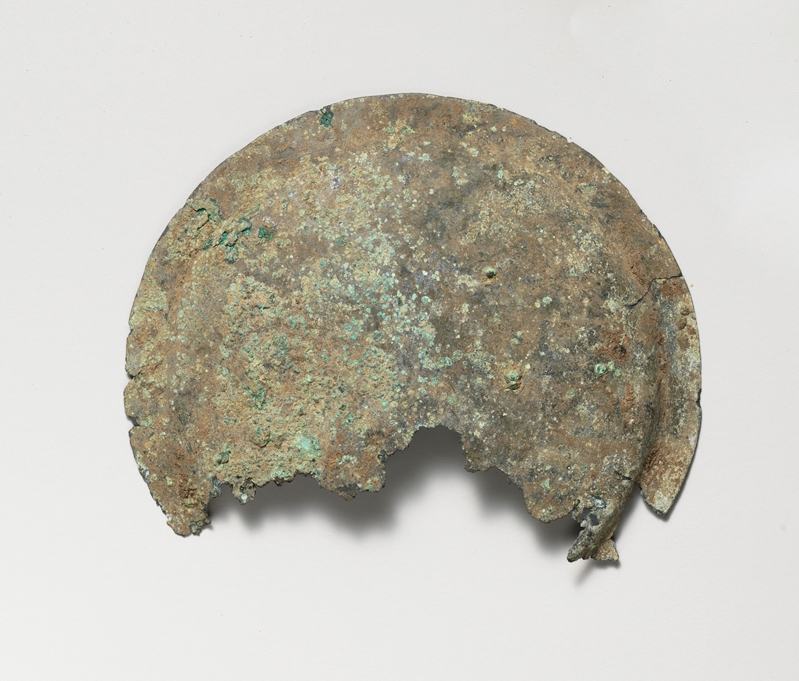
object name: shield, miniature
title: Miniature bronze shield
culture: etruscan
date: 500-401 BCE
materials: bronze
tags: shields